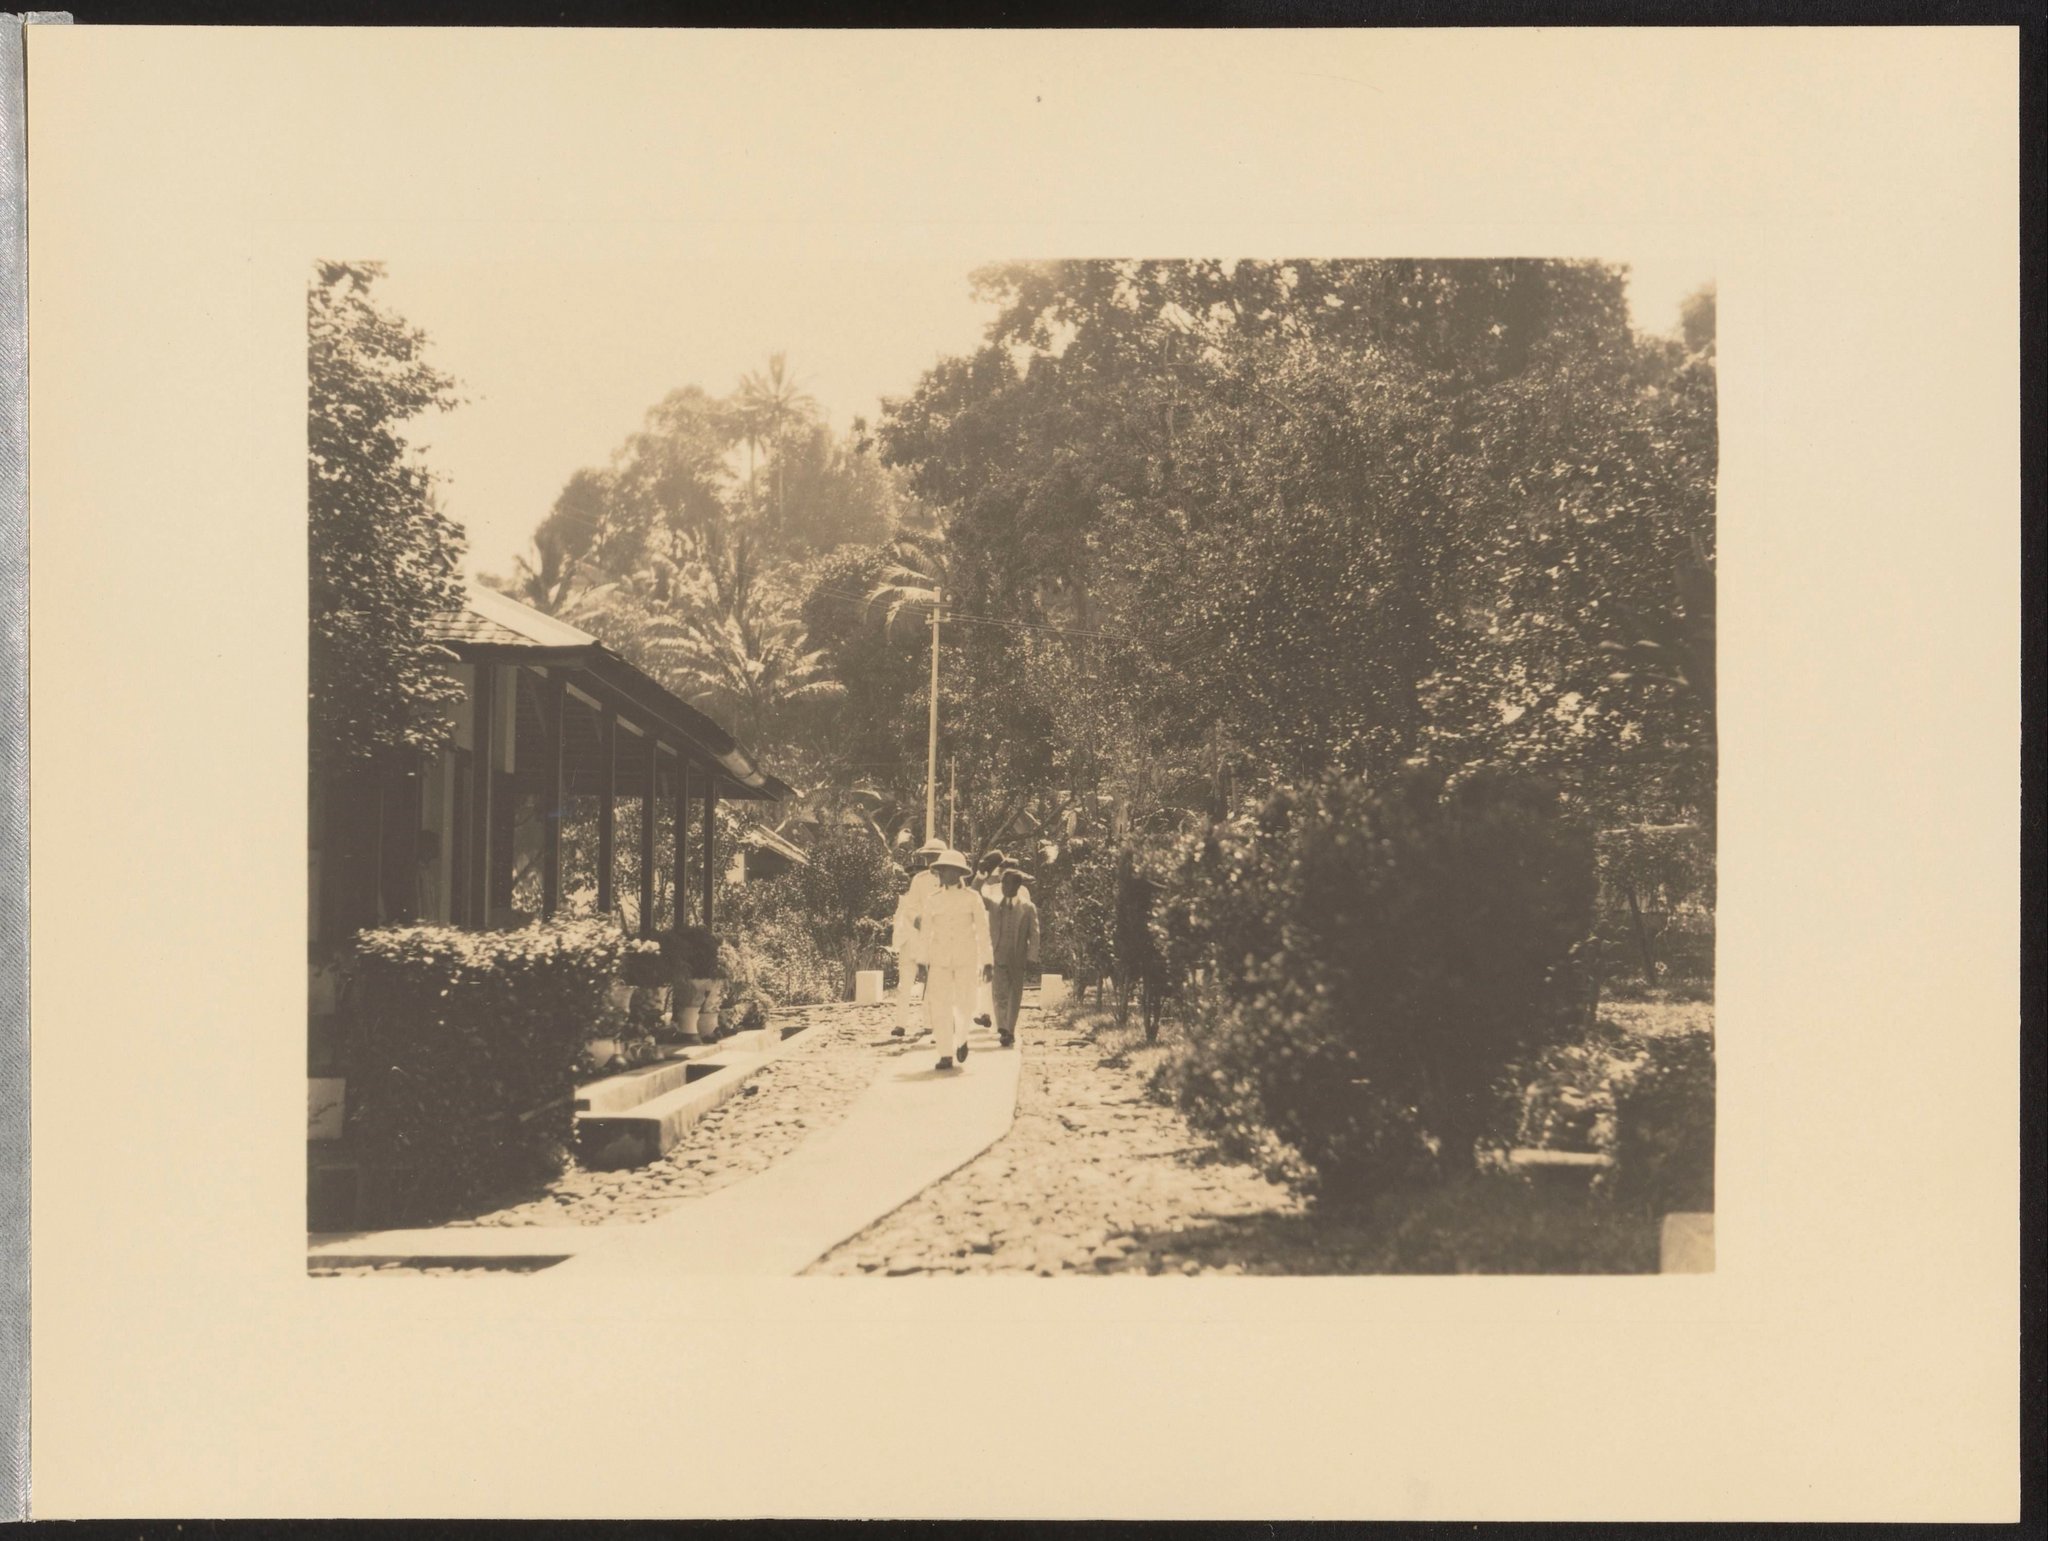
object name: photograph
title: Bezoek aan de leprozerie Pelantoengan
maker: otto hisgen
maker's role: fotograaf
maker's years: 1874-1944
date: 1905-1931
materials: photographic support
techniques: photography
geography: pelatoengan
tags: the hague, leprosarium, colonial government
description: De delegatie met gouverneur A.H. Neijs lopend tussen de gebouwen van de Semarang-leprozerie in Pelantoengan in mei 1931. Losse foto in de map met herinneringsfoto's van het bezoek aangeboden aan gouverneur A.H. Neijs.